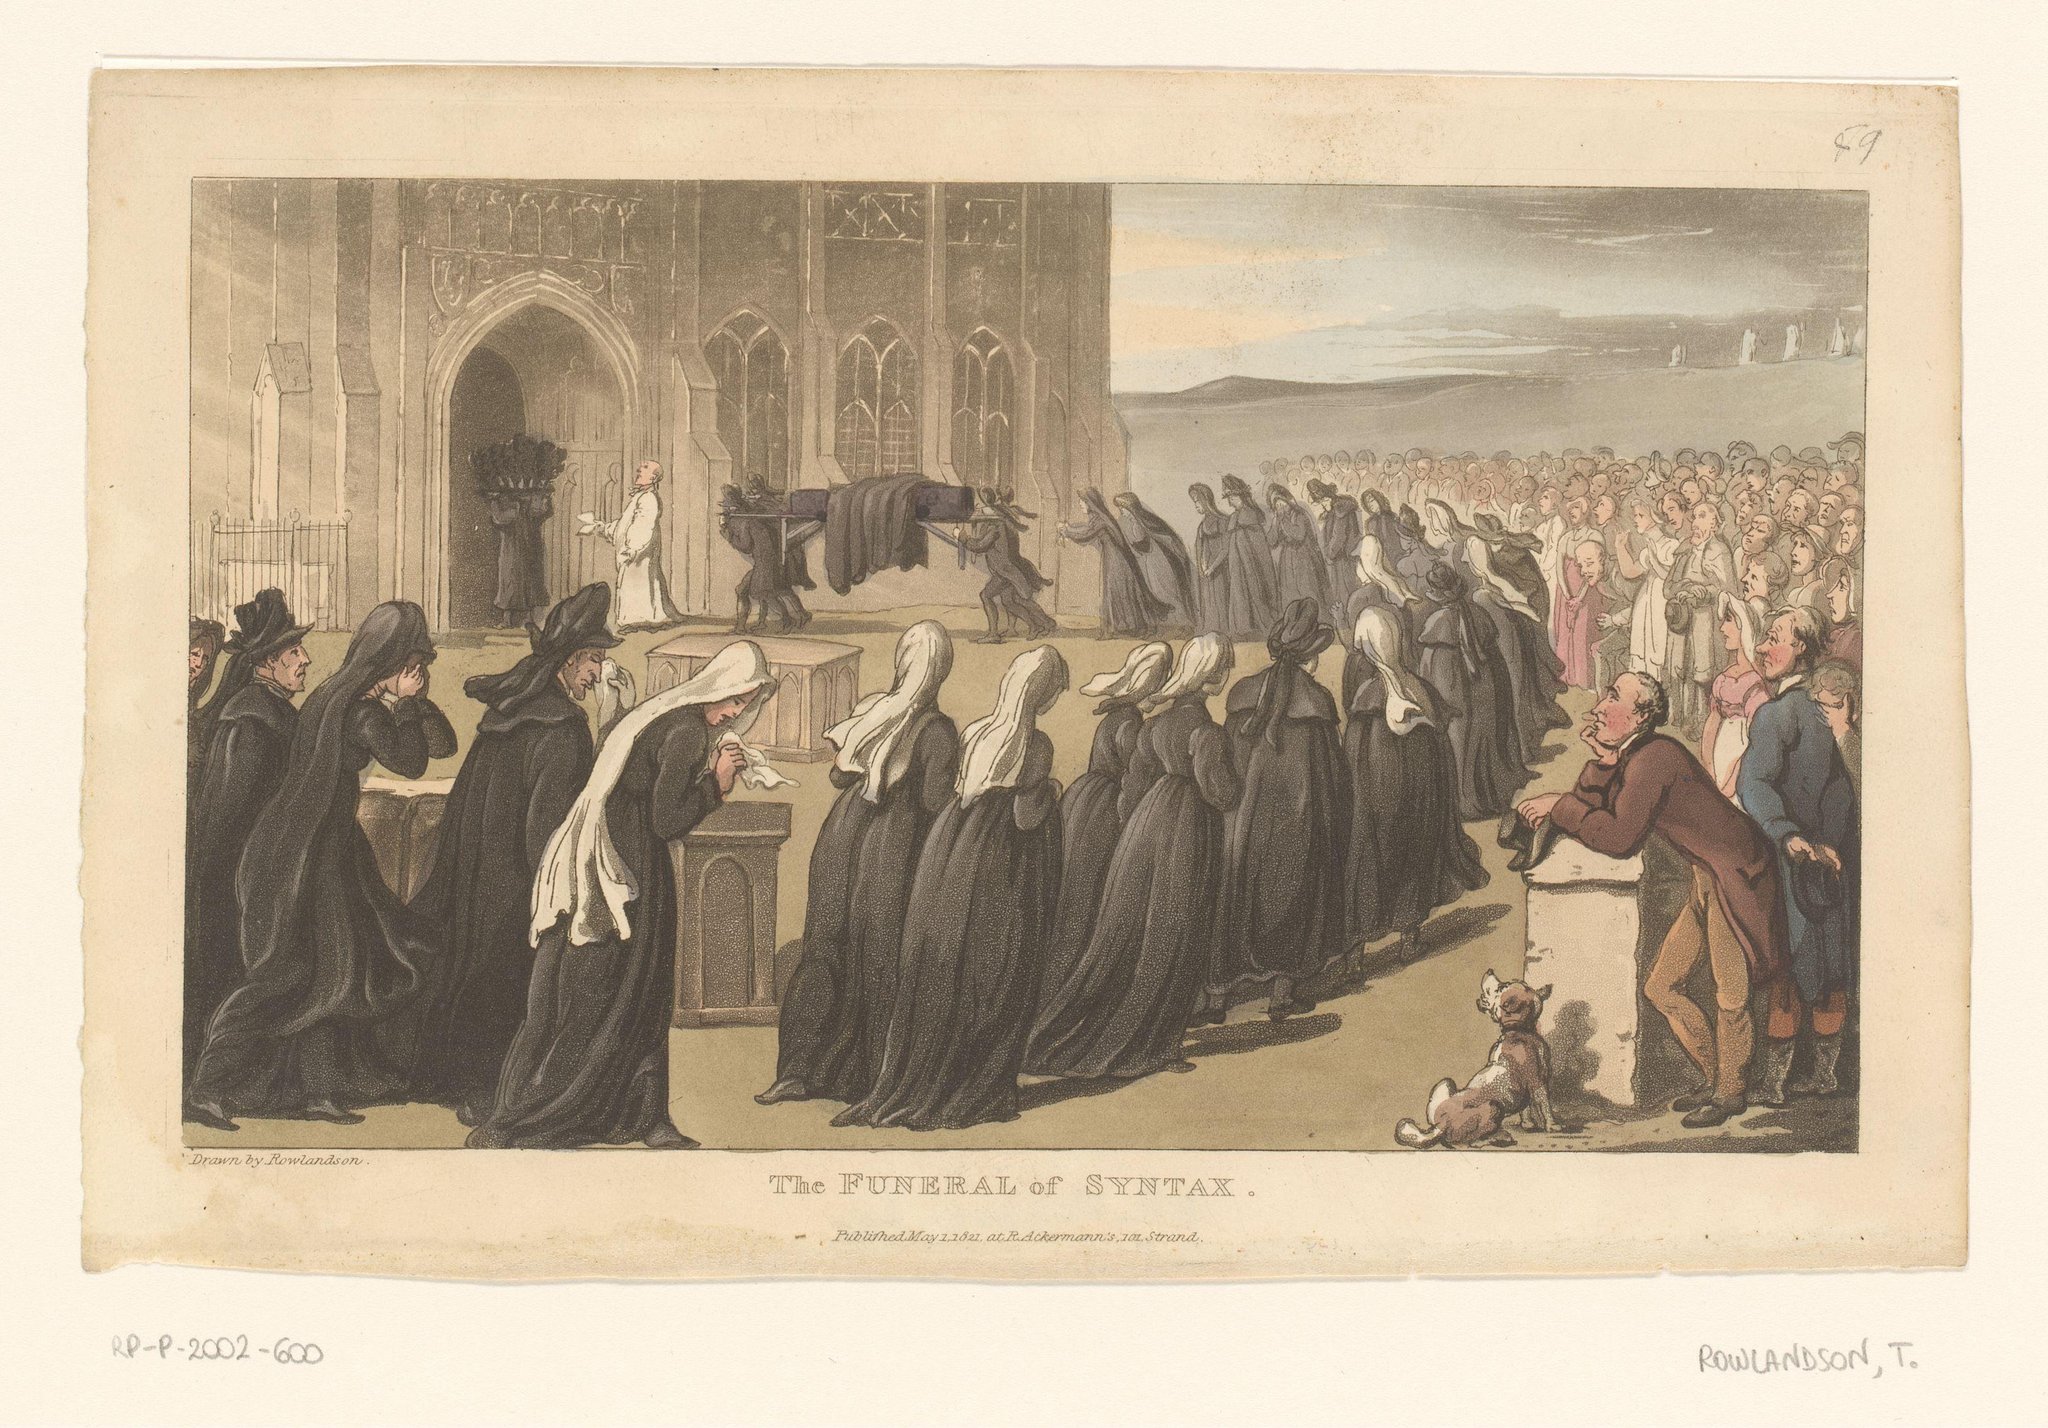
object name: print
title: Begrafenis van Syntax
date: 1805-1821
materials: paper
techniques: aquatint, etching, hand coloring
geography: london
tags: cortege, funeral procession, church (exterior), mourning the dead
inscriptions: collector's mark: Lugt 2228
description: Prent ook gebruikt in: Combe, William. The Third Tour of Doctor Syntax, in Search of a Wife: A Poem. Londen: Rudolph Ackermann, 1821.